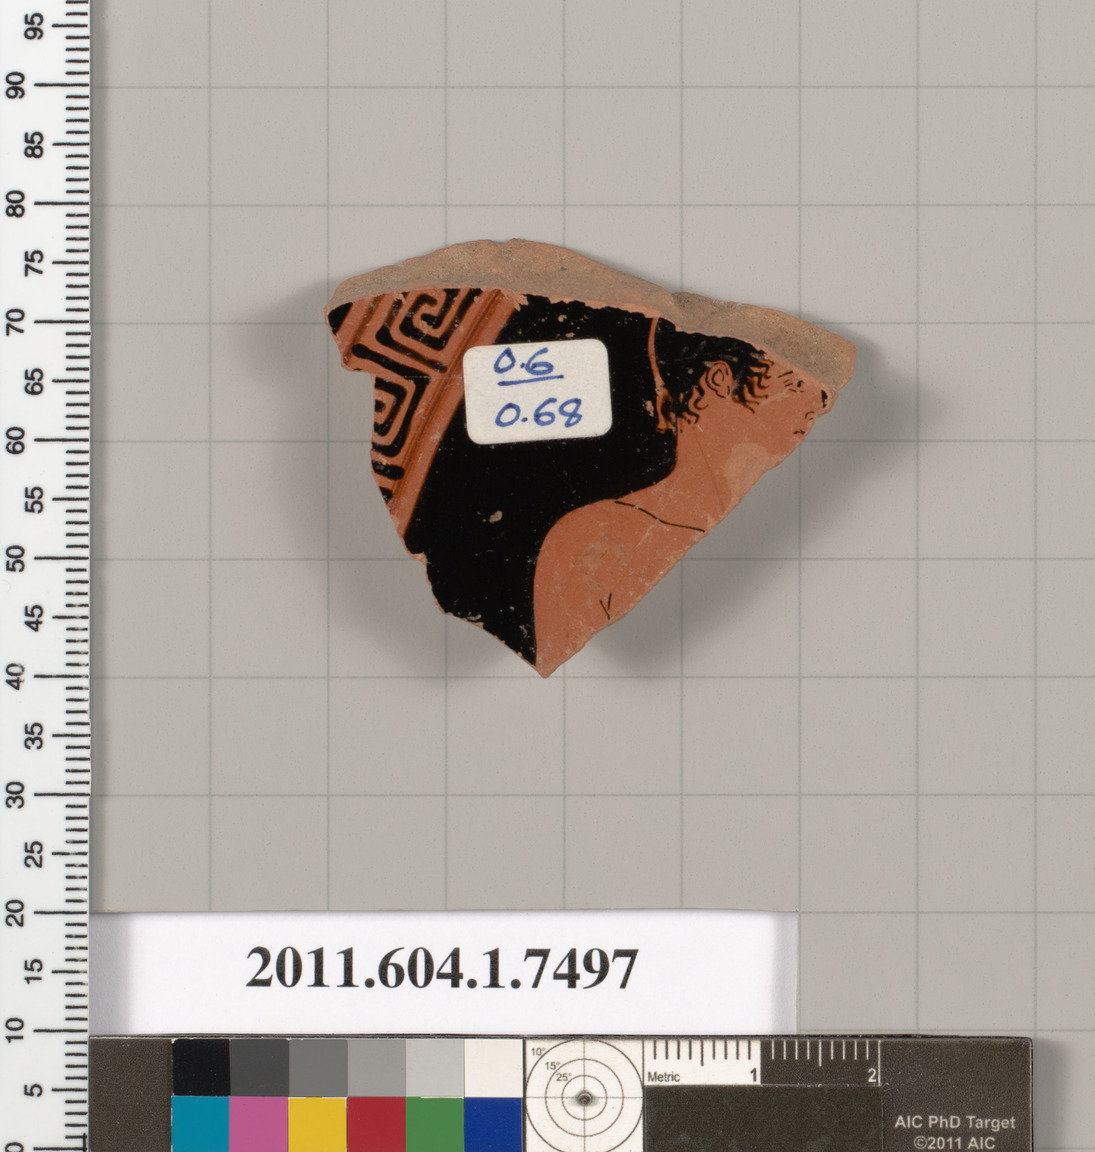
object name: kylix fragment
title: Terracotta fragment of a kylix (drinking cup)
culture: greek, attic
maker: euaion painter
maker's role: artist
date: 460-450 BCE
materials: terracotta